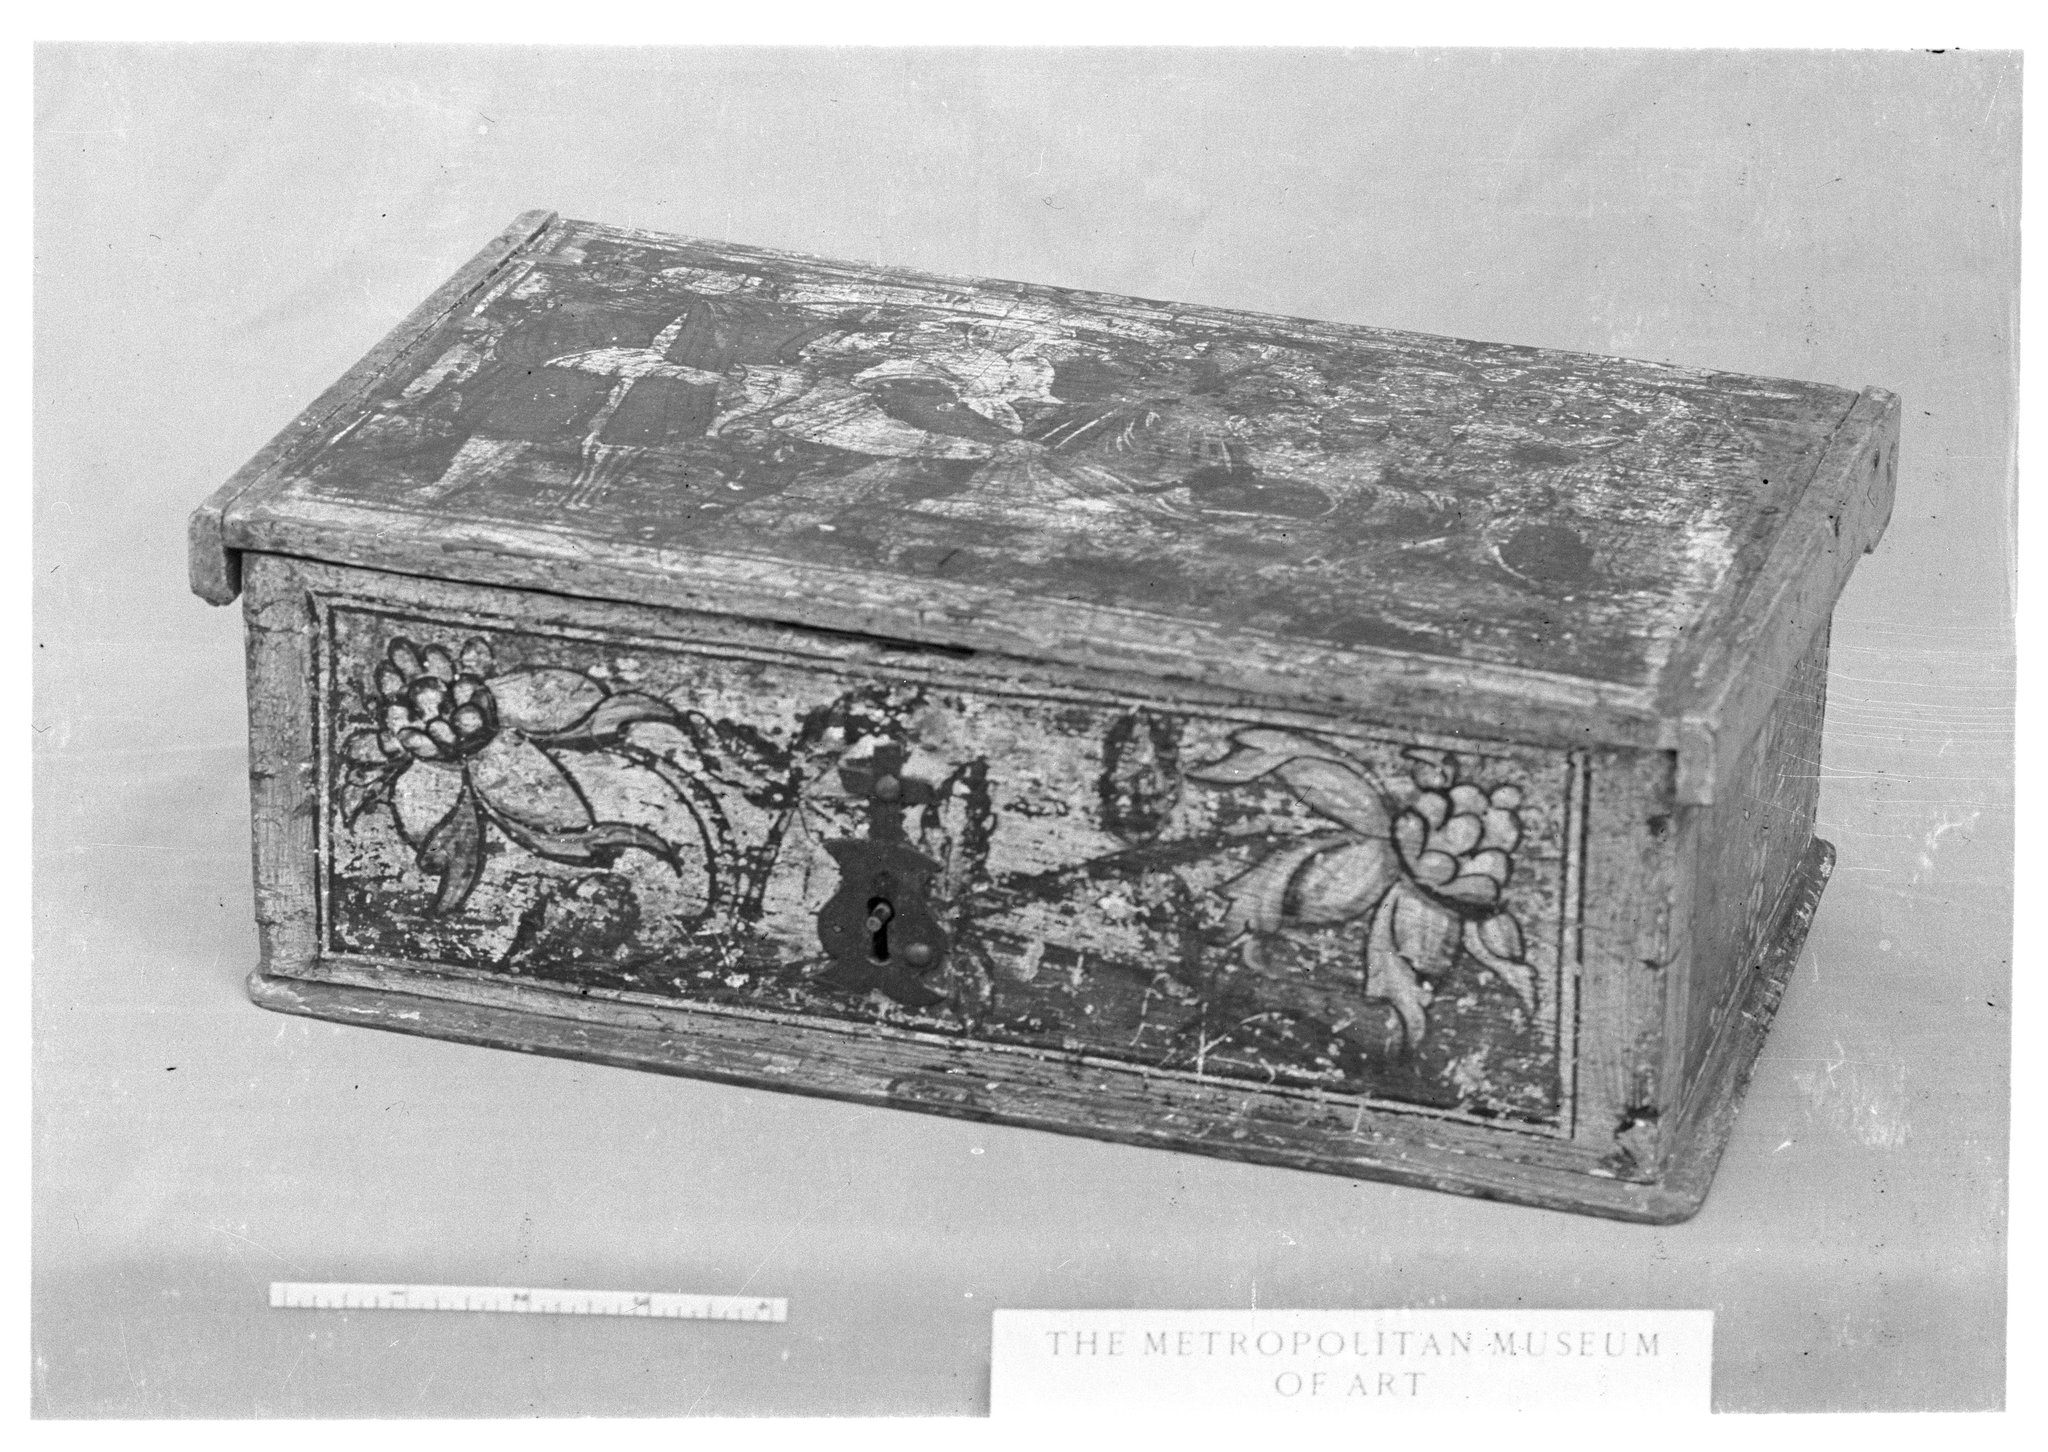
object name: box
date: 1501-1600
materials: wood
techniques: painting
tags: flowers